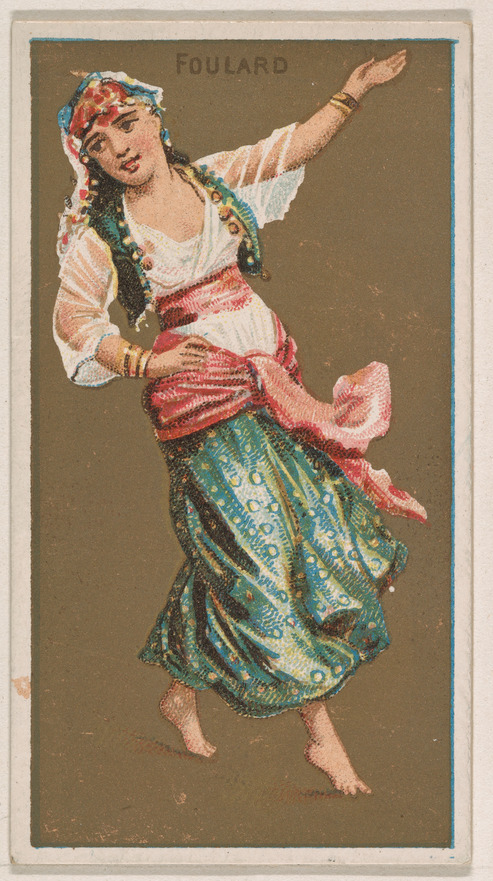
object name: print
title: Foulard, from National Dances (N225, Type 1) issued by Kinney Bros.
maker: kinney brothers tobacco company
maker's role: publisher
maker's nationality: american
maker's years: 1869-2011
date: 1889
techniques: color lithograph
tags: dance,women,dancers